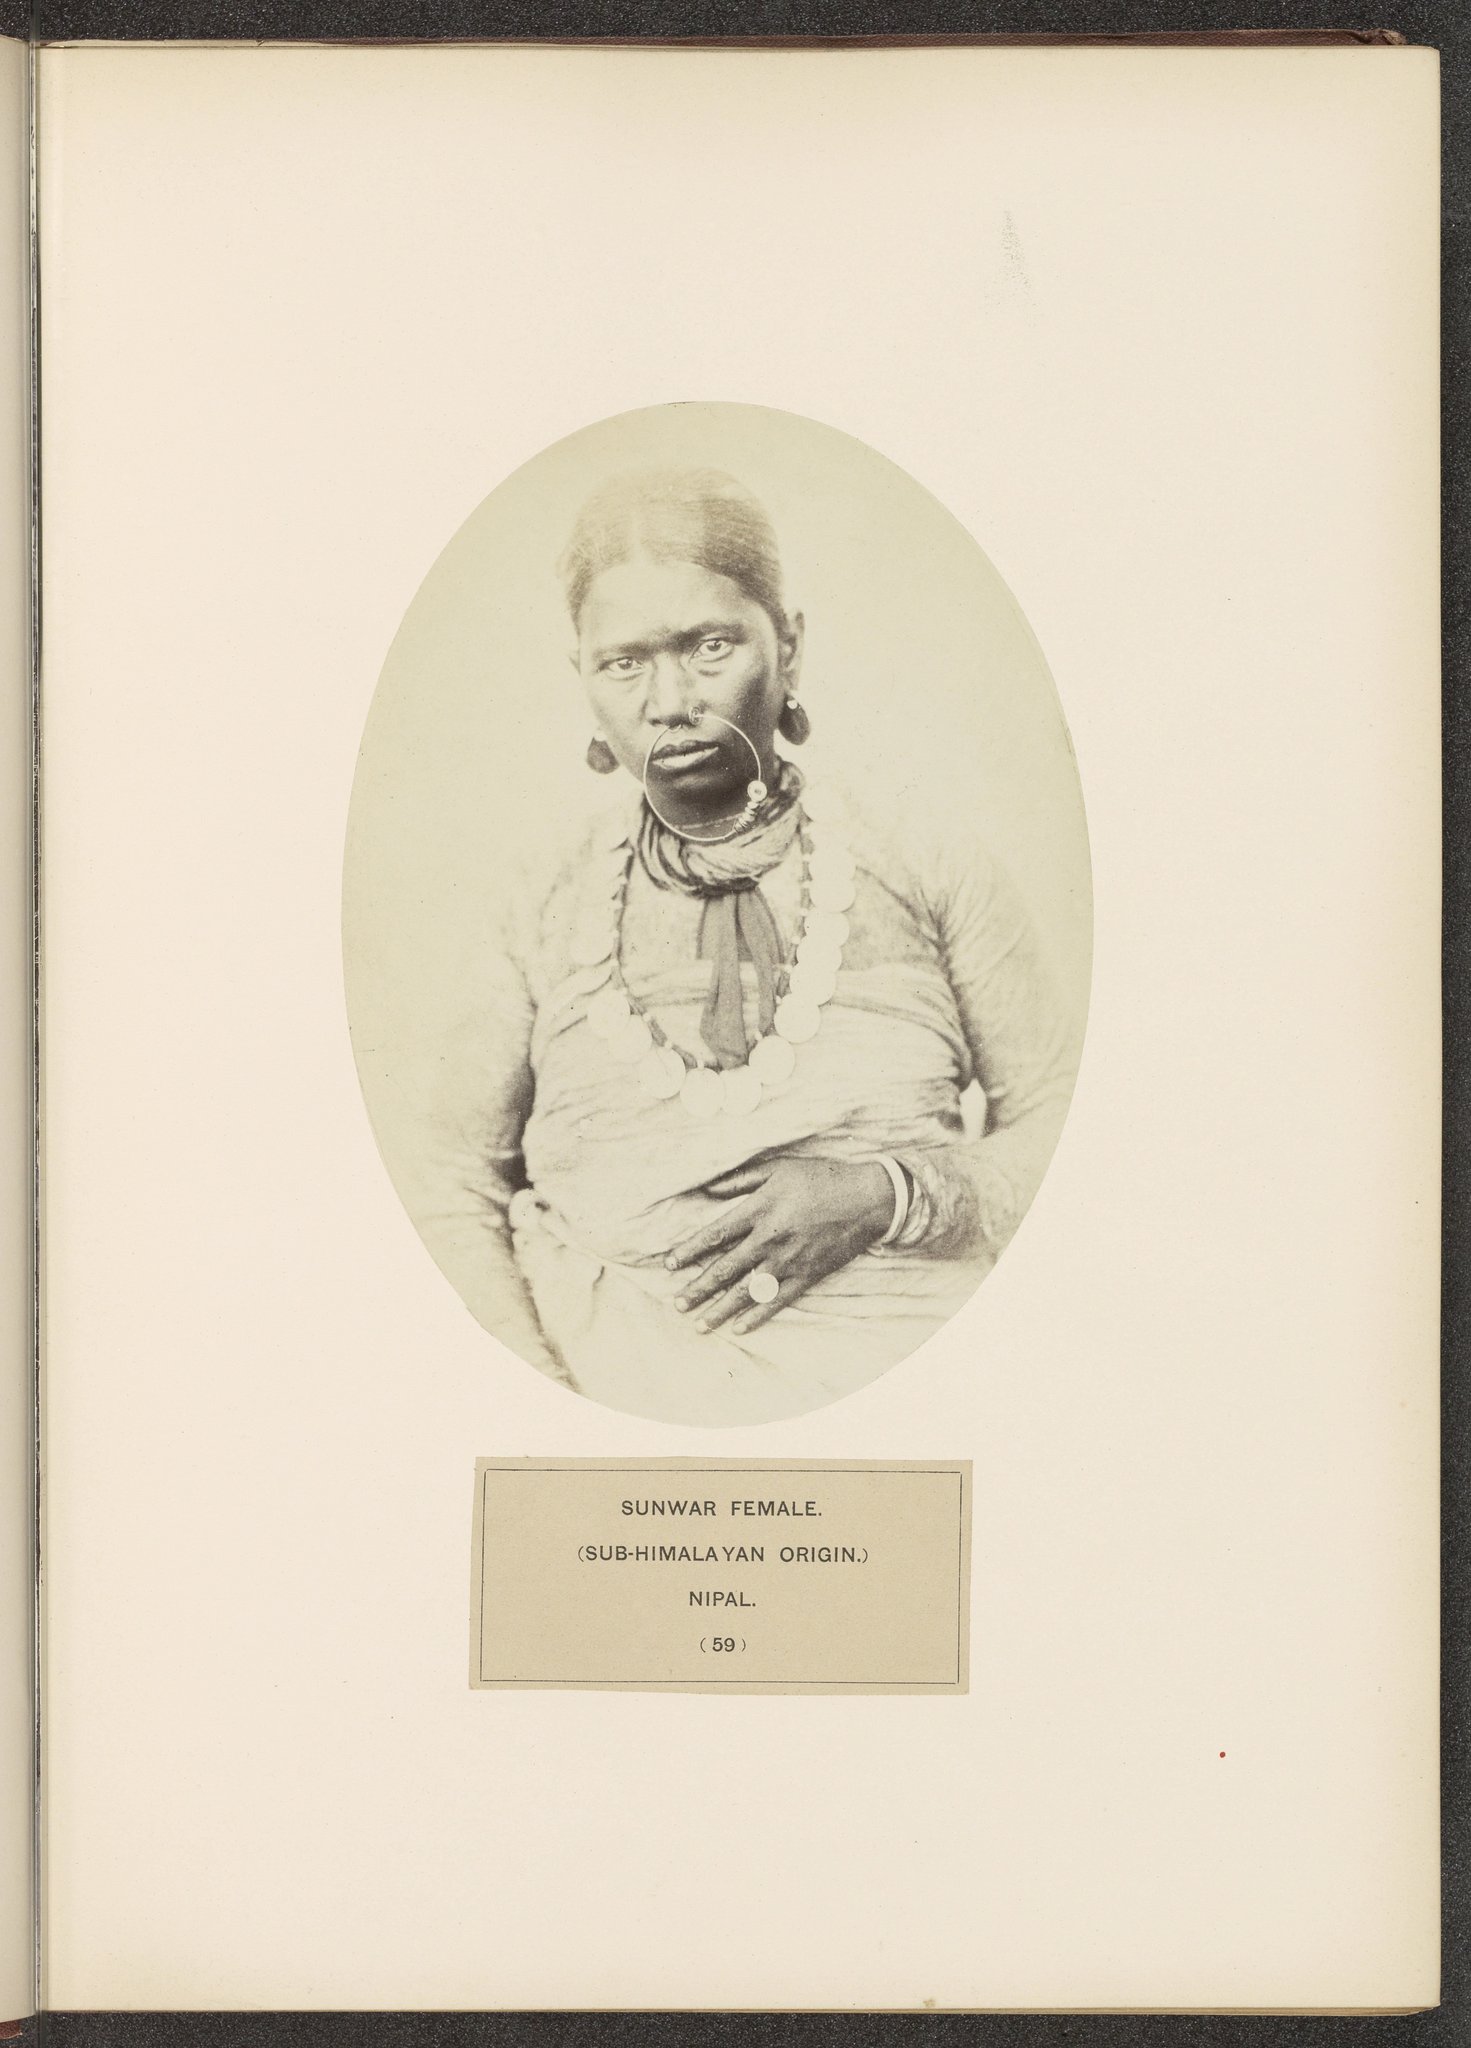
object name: photograph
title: Portrait of an unknown woman from the Sunuwar tribe of Nepal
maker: Anonymous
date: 1858-1868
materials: photographic support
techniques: albumen print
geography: nepal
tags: human races; peoples; nationalities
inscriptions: inscription: ‘SUNWAR FEMALE./ (SUB-HIMALAYAN ORIGIN.)/ NIPAL.’, number: ‘(59)’